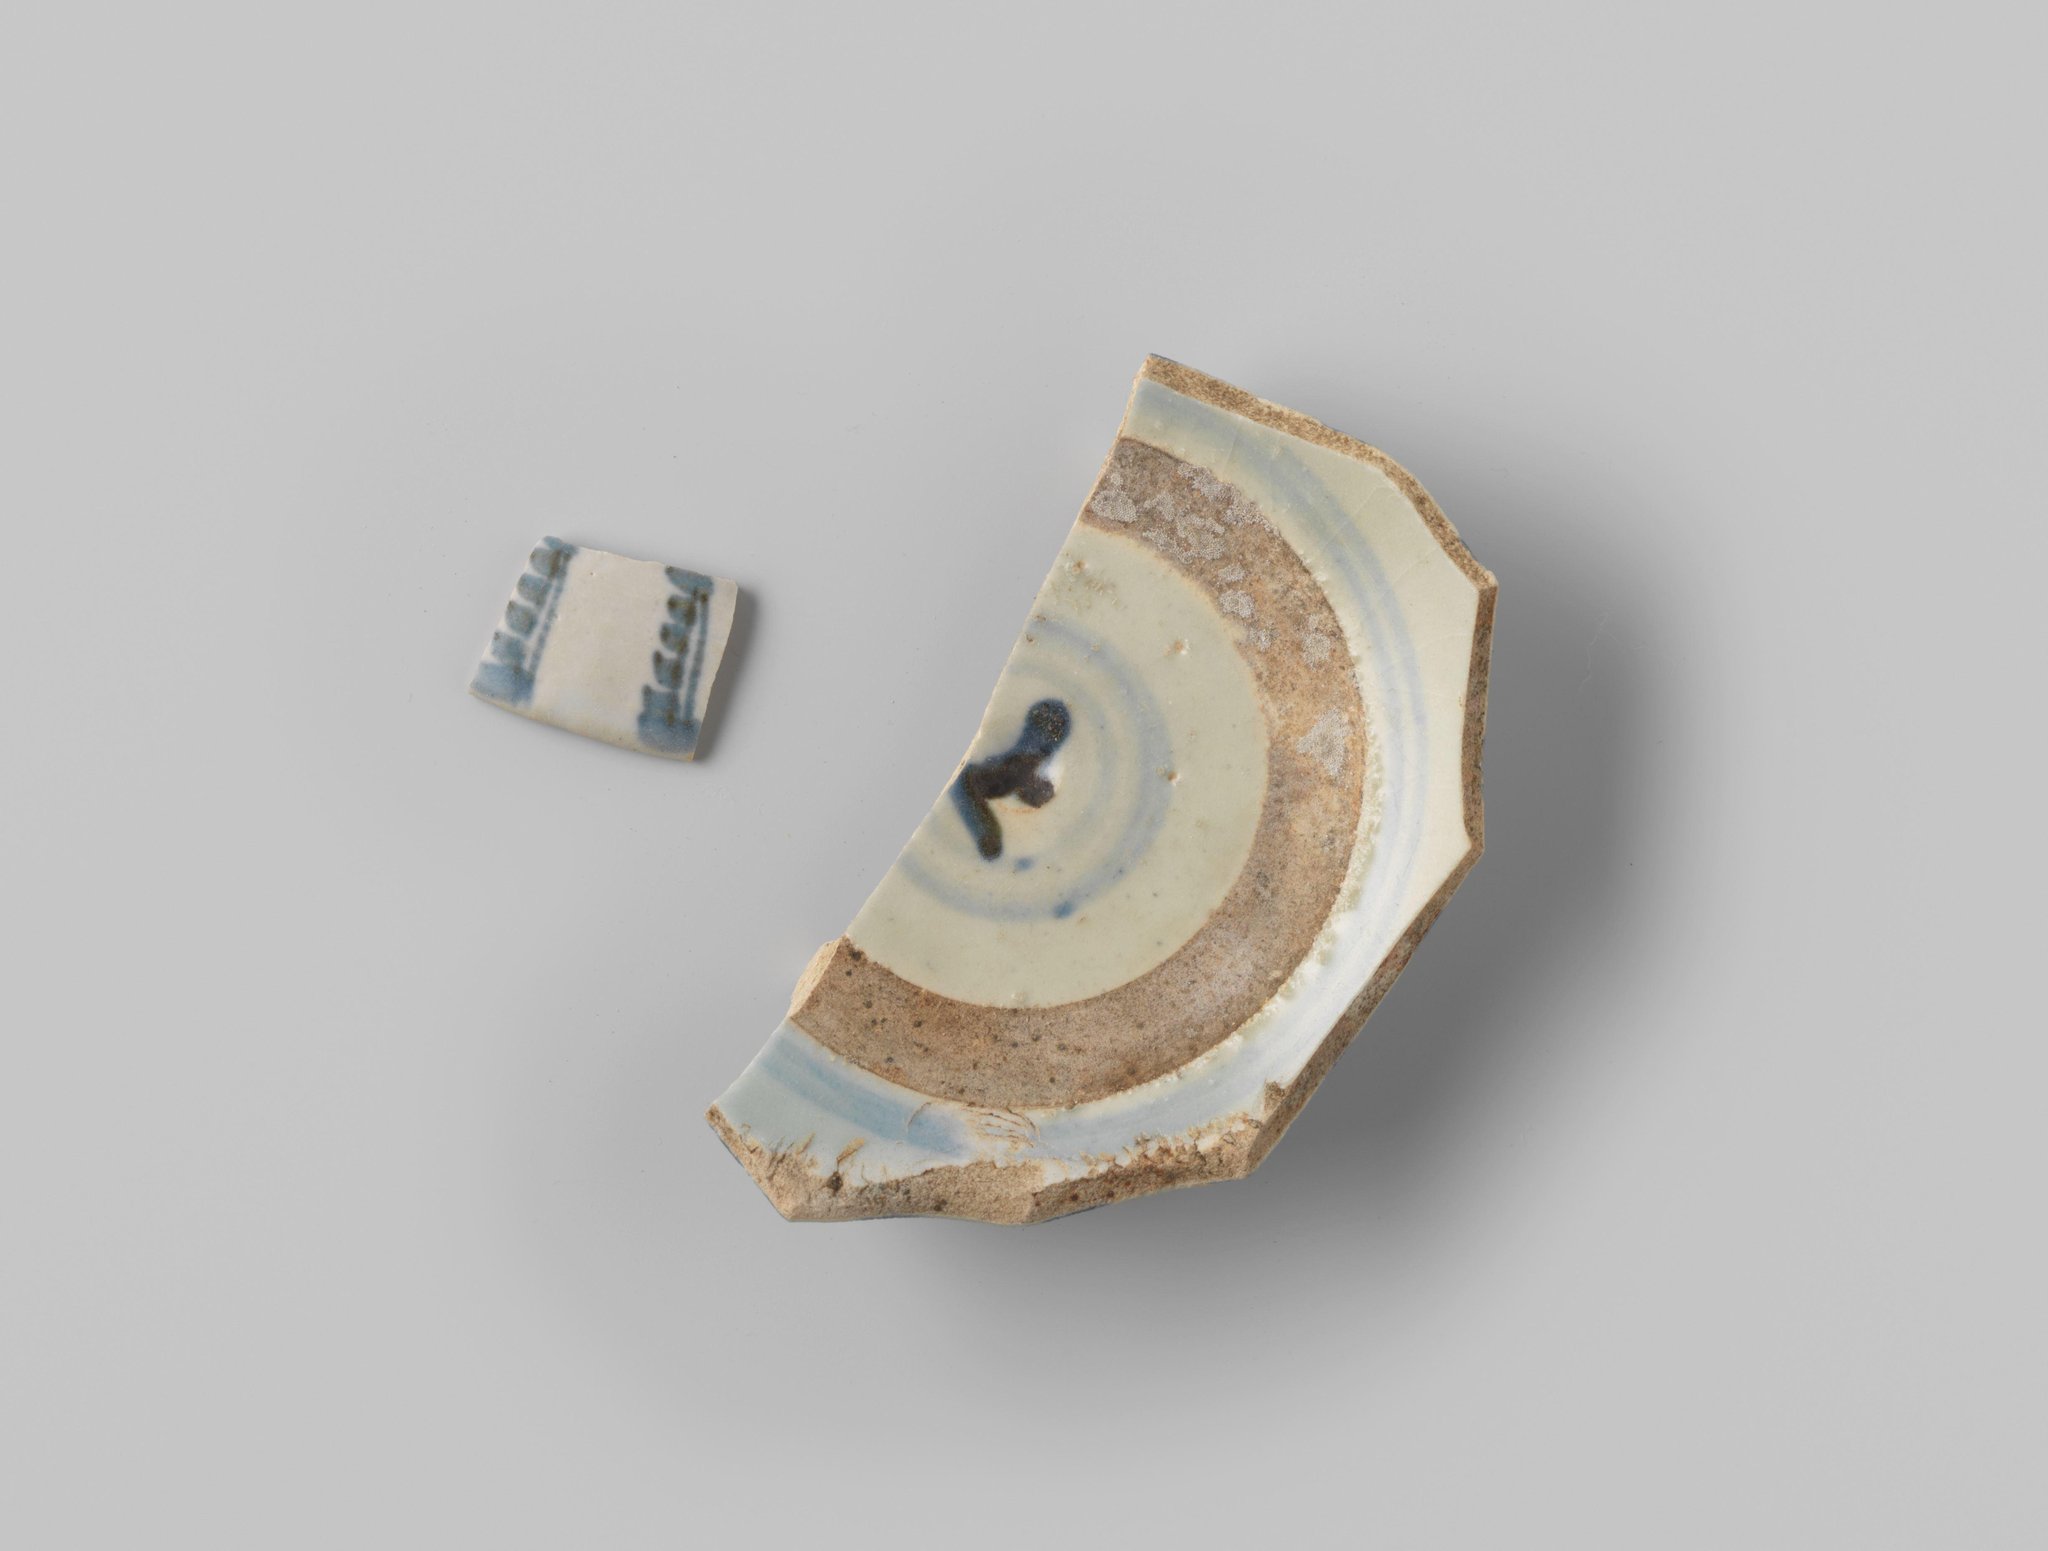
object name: sherd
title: Scherven van een kom uit V.O.C.-schip de 'Witte Leeuw'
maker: Anonymous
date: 1613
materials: porcelain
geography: shantou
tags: verenigde oostindische compagnie, sint-helena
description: A bowl with an unglazed ring. Around the centre an unglazed band. On the outside a band of comb-decoration.